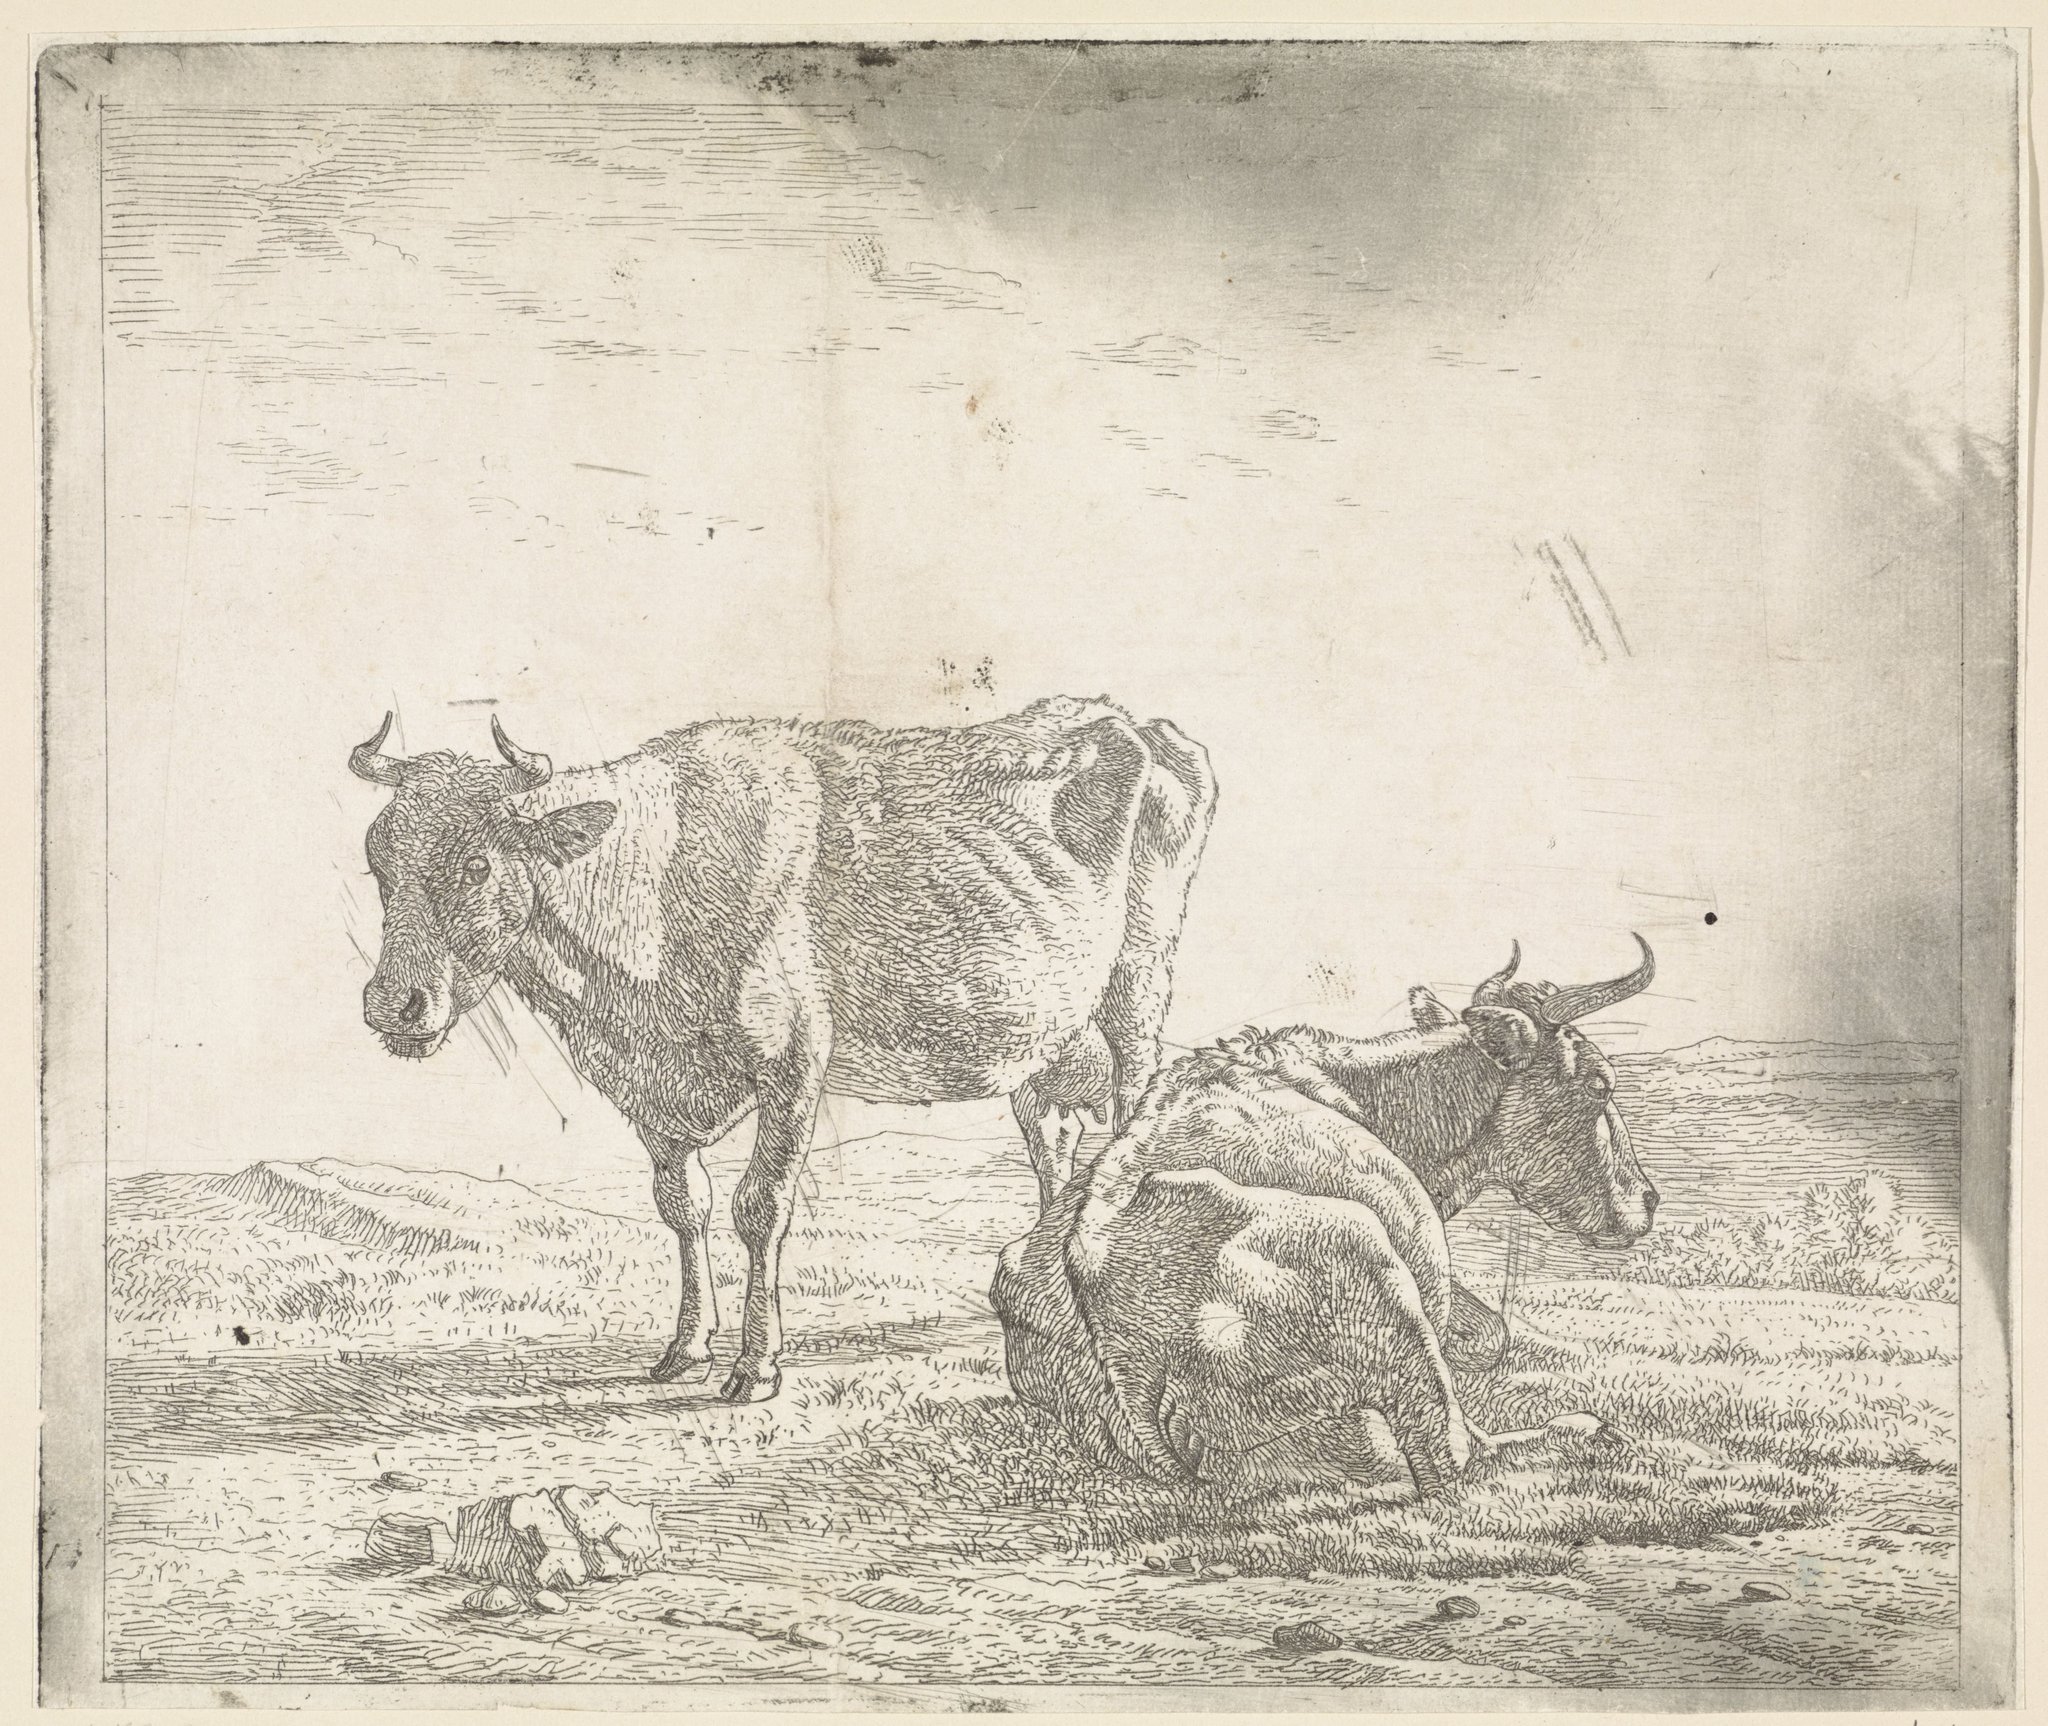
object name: print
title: Weiland met een staande en liggende koe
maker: wouter johannes van troostwijk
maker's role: draughtsman, painter, print maker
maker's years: 1782-1810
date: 1792-1810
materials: paper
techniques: etching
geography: amsterdam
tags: cow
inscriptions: collector's mark: Lugt 2165